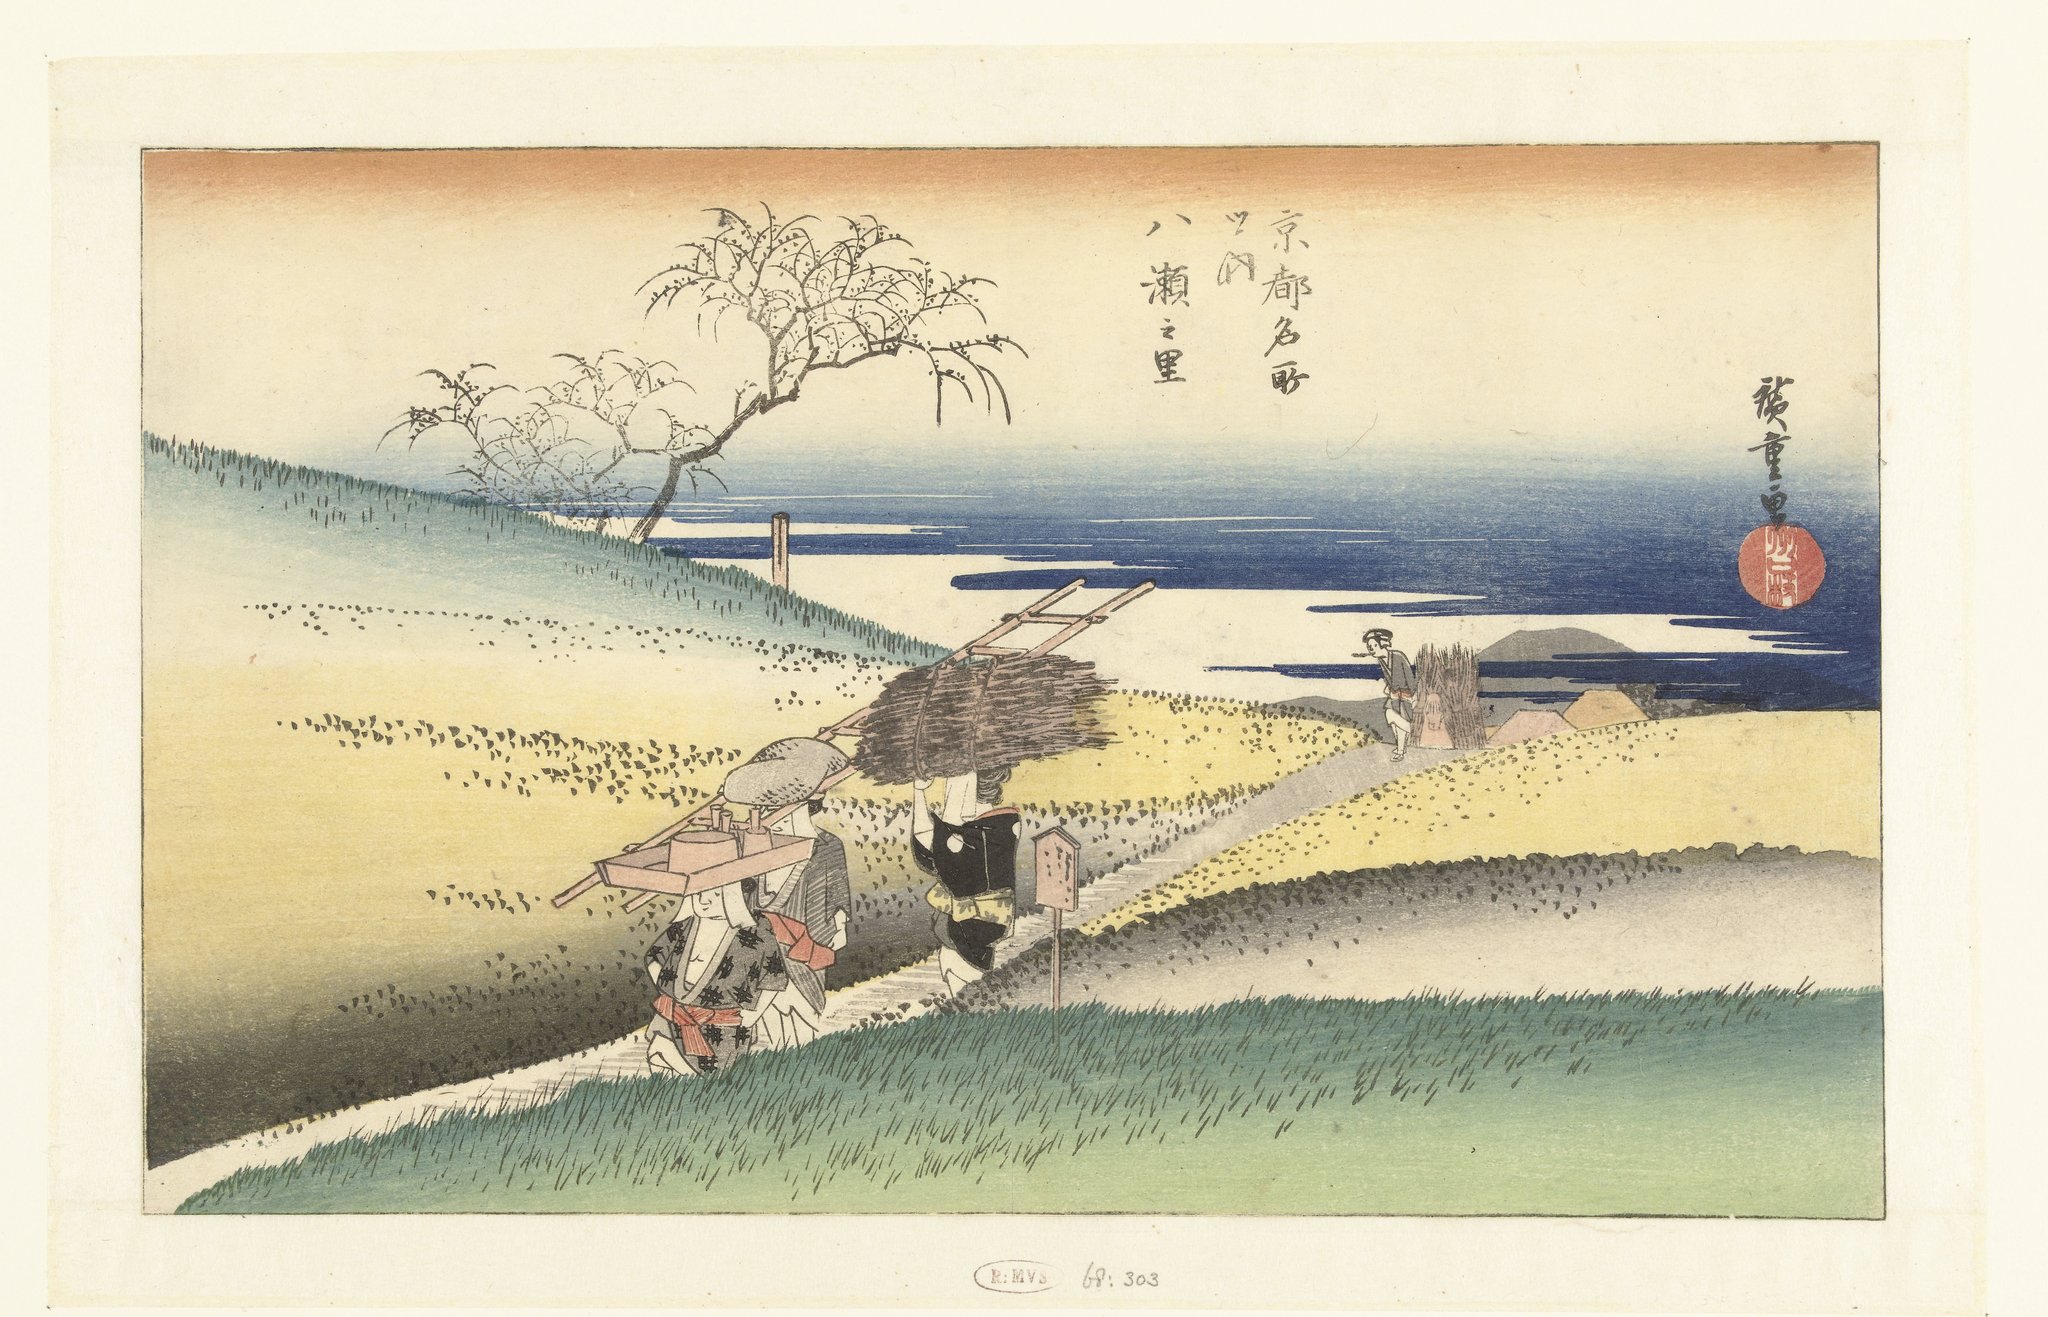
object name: print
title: Beroemde plaatsten in Kyoto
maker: utagawa hiroshige (i)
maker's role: draughtsman, print maker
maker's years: 1797-1858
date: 1833-1837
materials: paper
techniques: woodcut, nishiki e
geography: japan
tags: walking, coast, carrying something on the head or on the shoulders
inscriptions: collector's mark: Lugt 2228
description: Drie vrouwen, verschillende materialen en voorwerpen op het hoofd dragend, lopend tussen groene heuvels; op de achtergrond een man een paard voorttrekkend en de daken van het dorp Yase. Vrouwen uit Yase stonden erom bekend ladingen op hun hoofd te vervoeren.